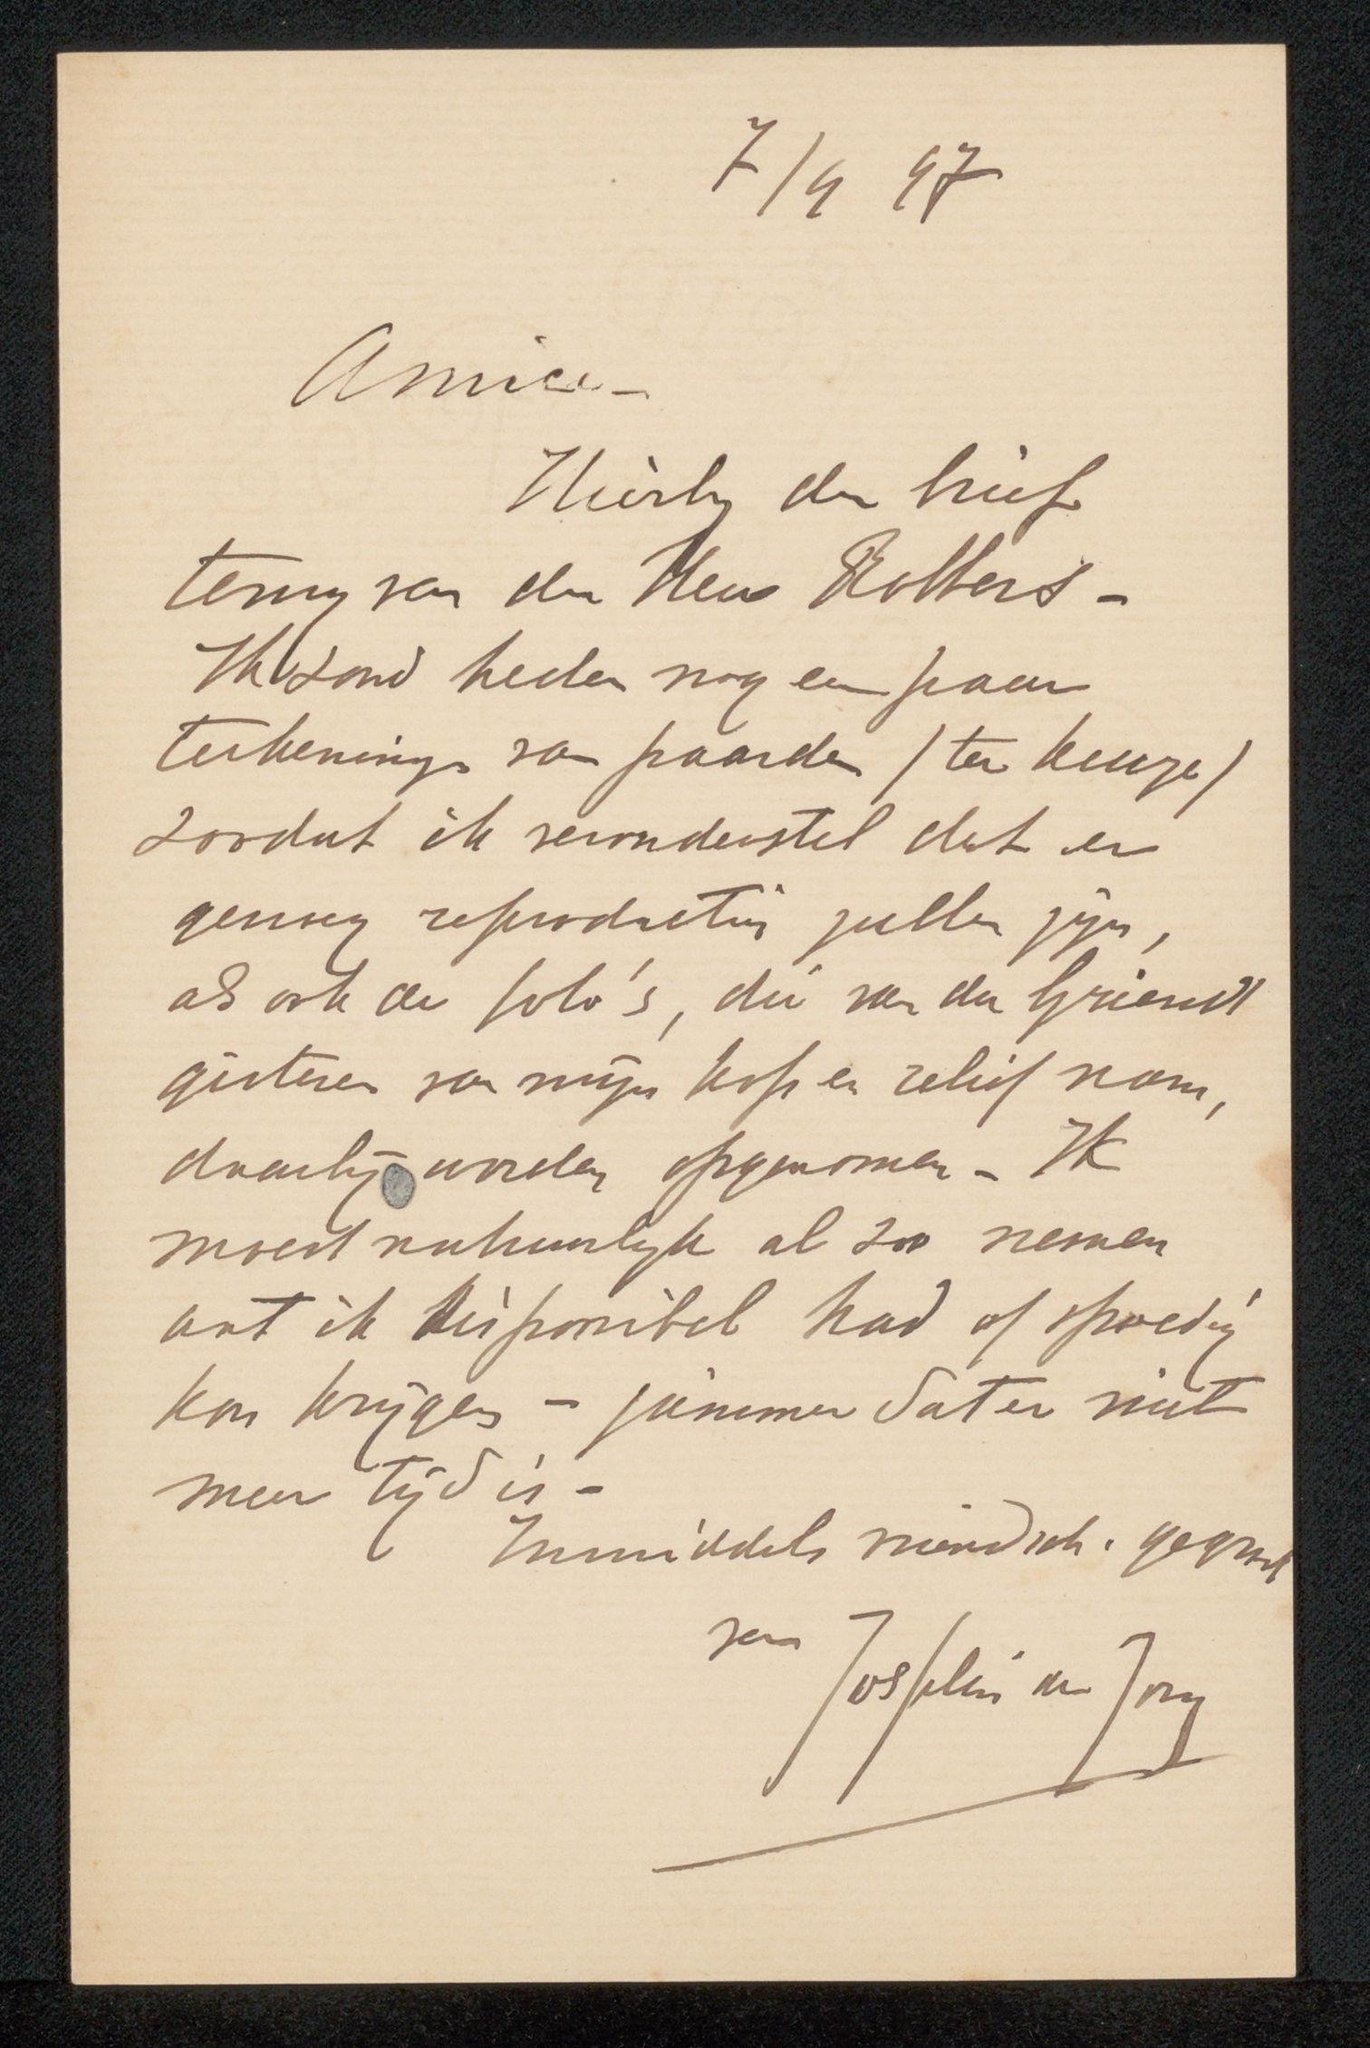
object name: letter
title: Brief aan Philip Zilcken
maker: pieter de josselin de jong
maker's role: draughtsman, painter, print maker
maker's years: 1861-1906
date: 1897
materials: ink, paper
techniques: writing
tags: print maker, pieter de josselin de jong, rotterdam, amsterdam, herman robbers, painter, draughtsman, philip zilcken, drawing, photography, cinematography, historical persons (portraits and scenes from the life)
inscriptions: collector's mark: ‘RPK’